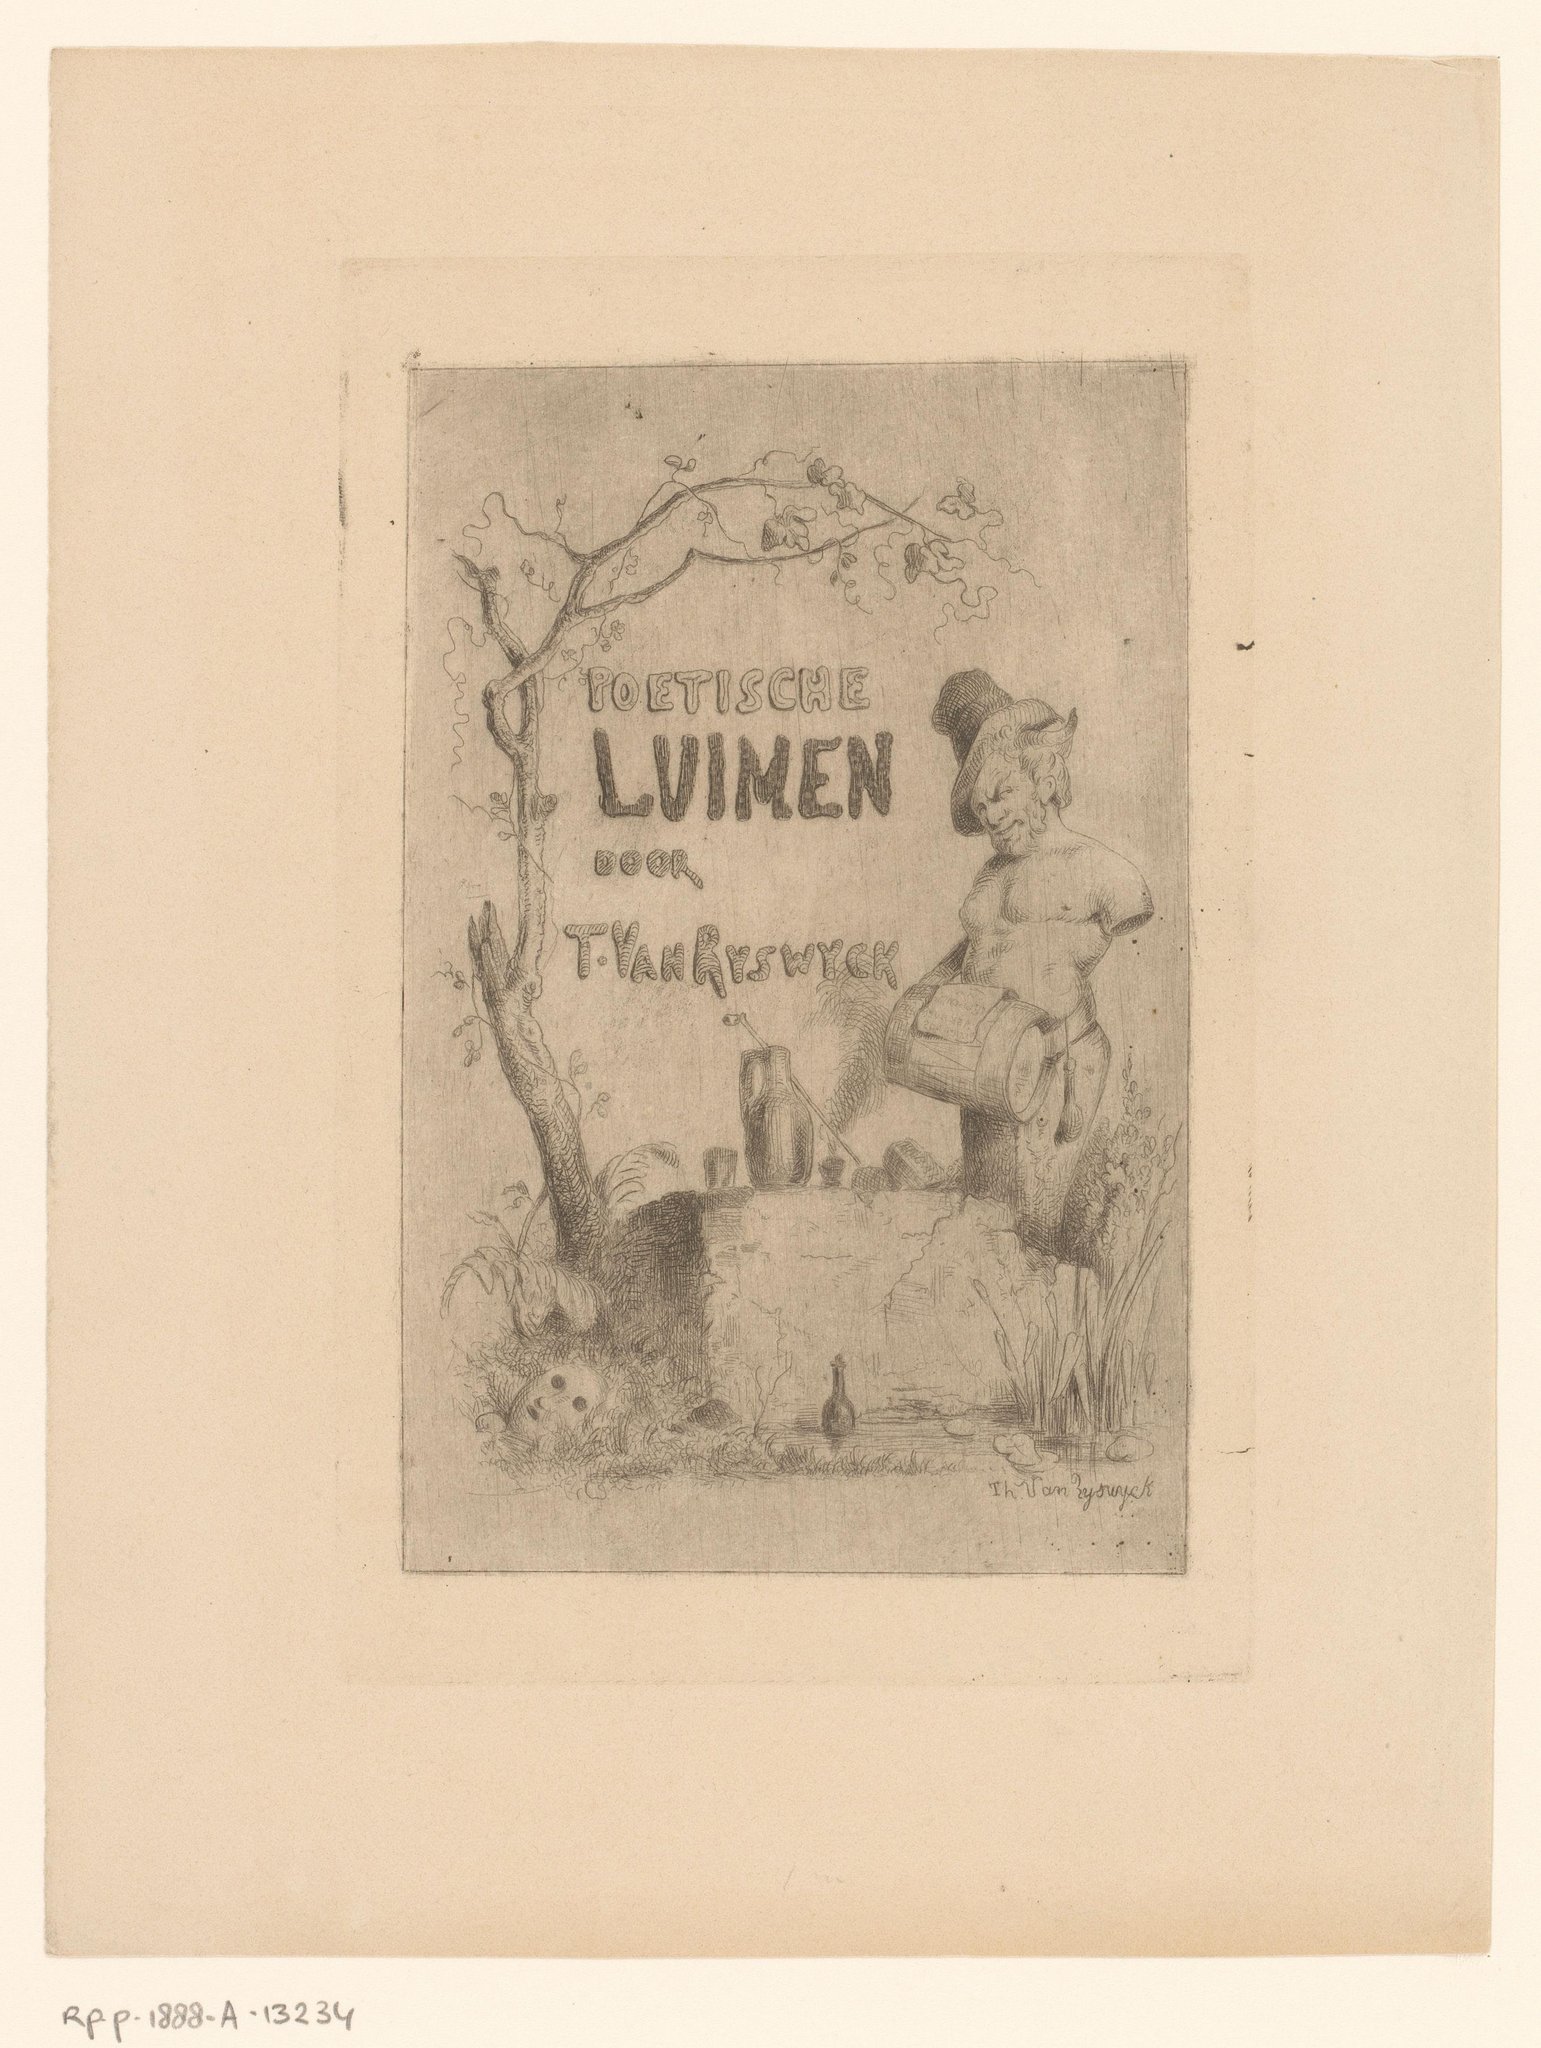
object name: titelblad, titelpagina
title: Poetische luimen door T. van Ryswyck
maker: theodor van ryswyck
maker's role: print maker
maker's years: 1811-1849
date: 1842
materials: paper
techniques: etching, intaglio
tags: head-gear: hat, satyr(s) (in general), drum (musical instrument) - cc - out of doors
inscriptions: collector's mark: Lugt 2228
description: Titelpagina voor: Van Ryswyck, Theodoor. Poëtische Luimen. Antwerpen: Gebroeders Dewever, 1842.